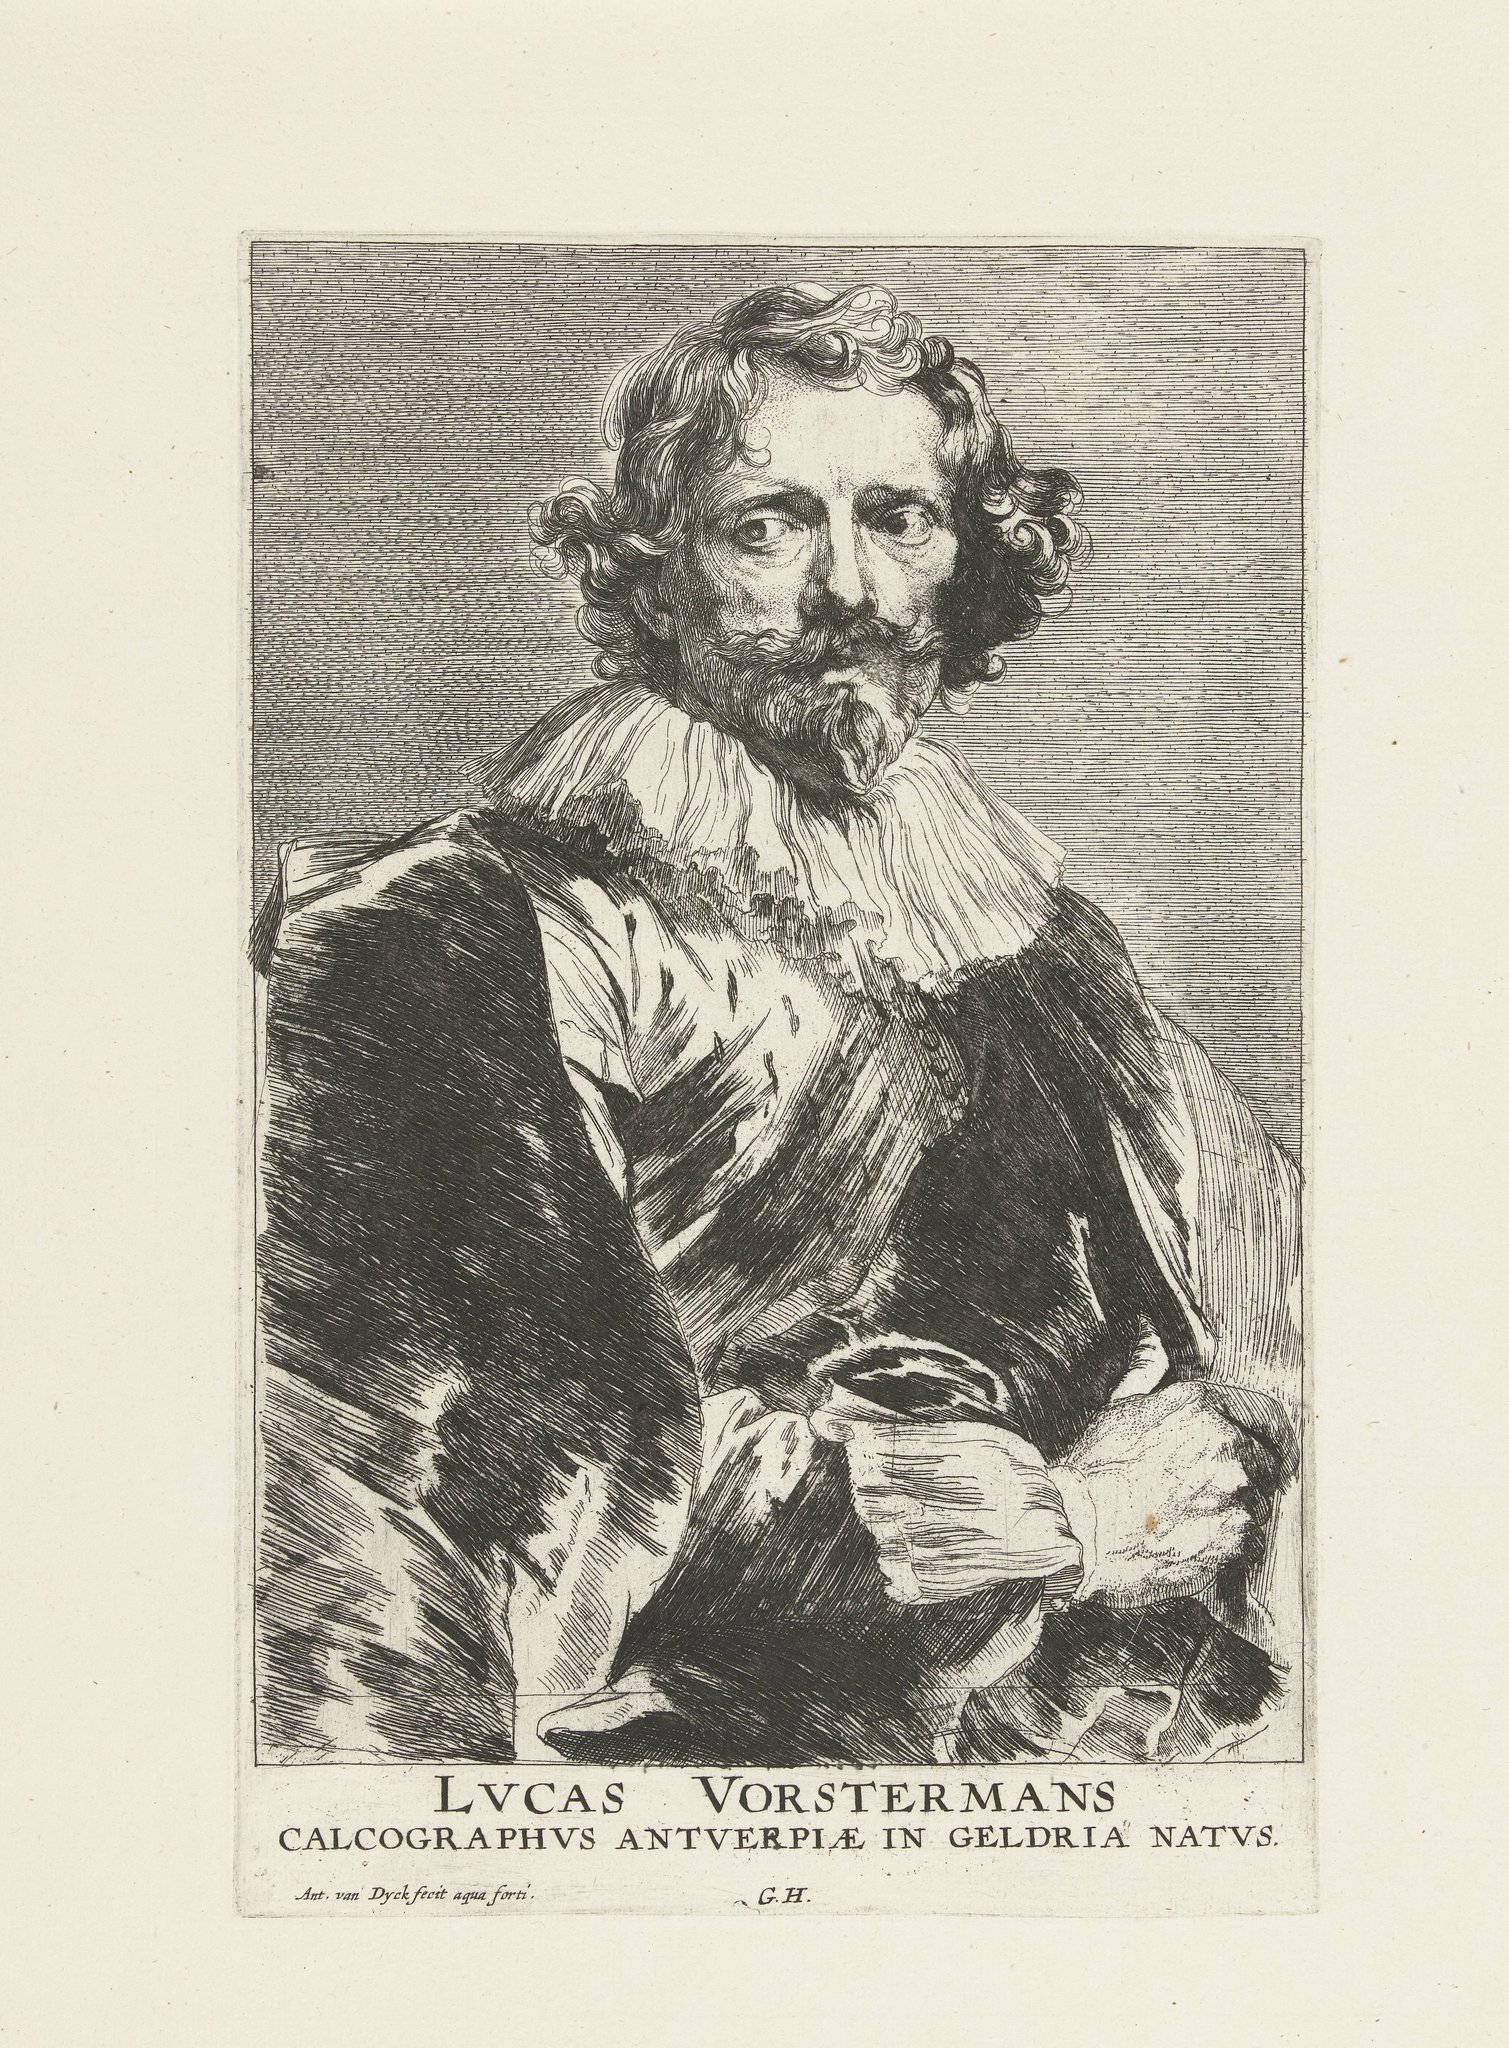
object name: print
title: Iconographie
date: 1630-1632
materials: paper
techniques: engraving, etching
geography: low countries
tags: lucas vorsterman, portrait, self-portrait of graphic artist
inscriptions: collector's mark: Lugt 2760, collector's mark: Lugt 2228a, collector's mark: Lugt 2166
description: Portret van Lucas Vorsterman I met onderschrift LVCAS VORSTERMANS CALCOGRAPHVS ANTVERPIAE IN GELDRIA NATVS